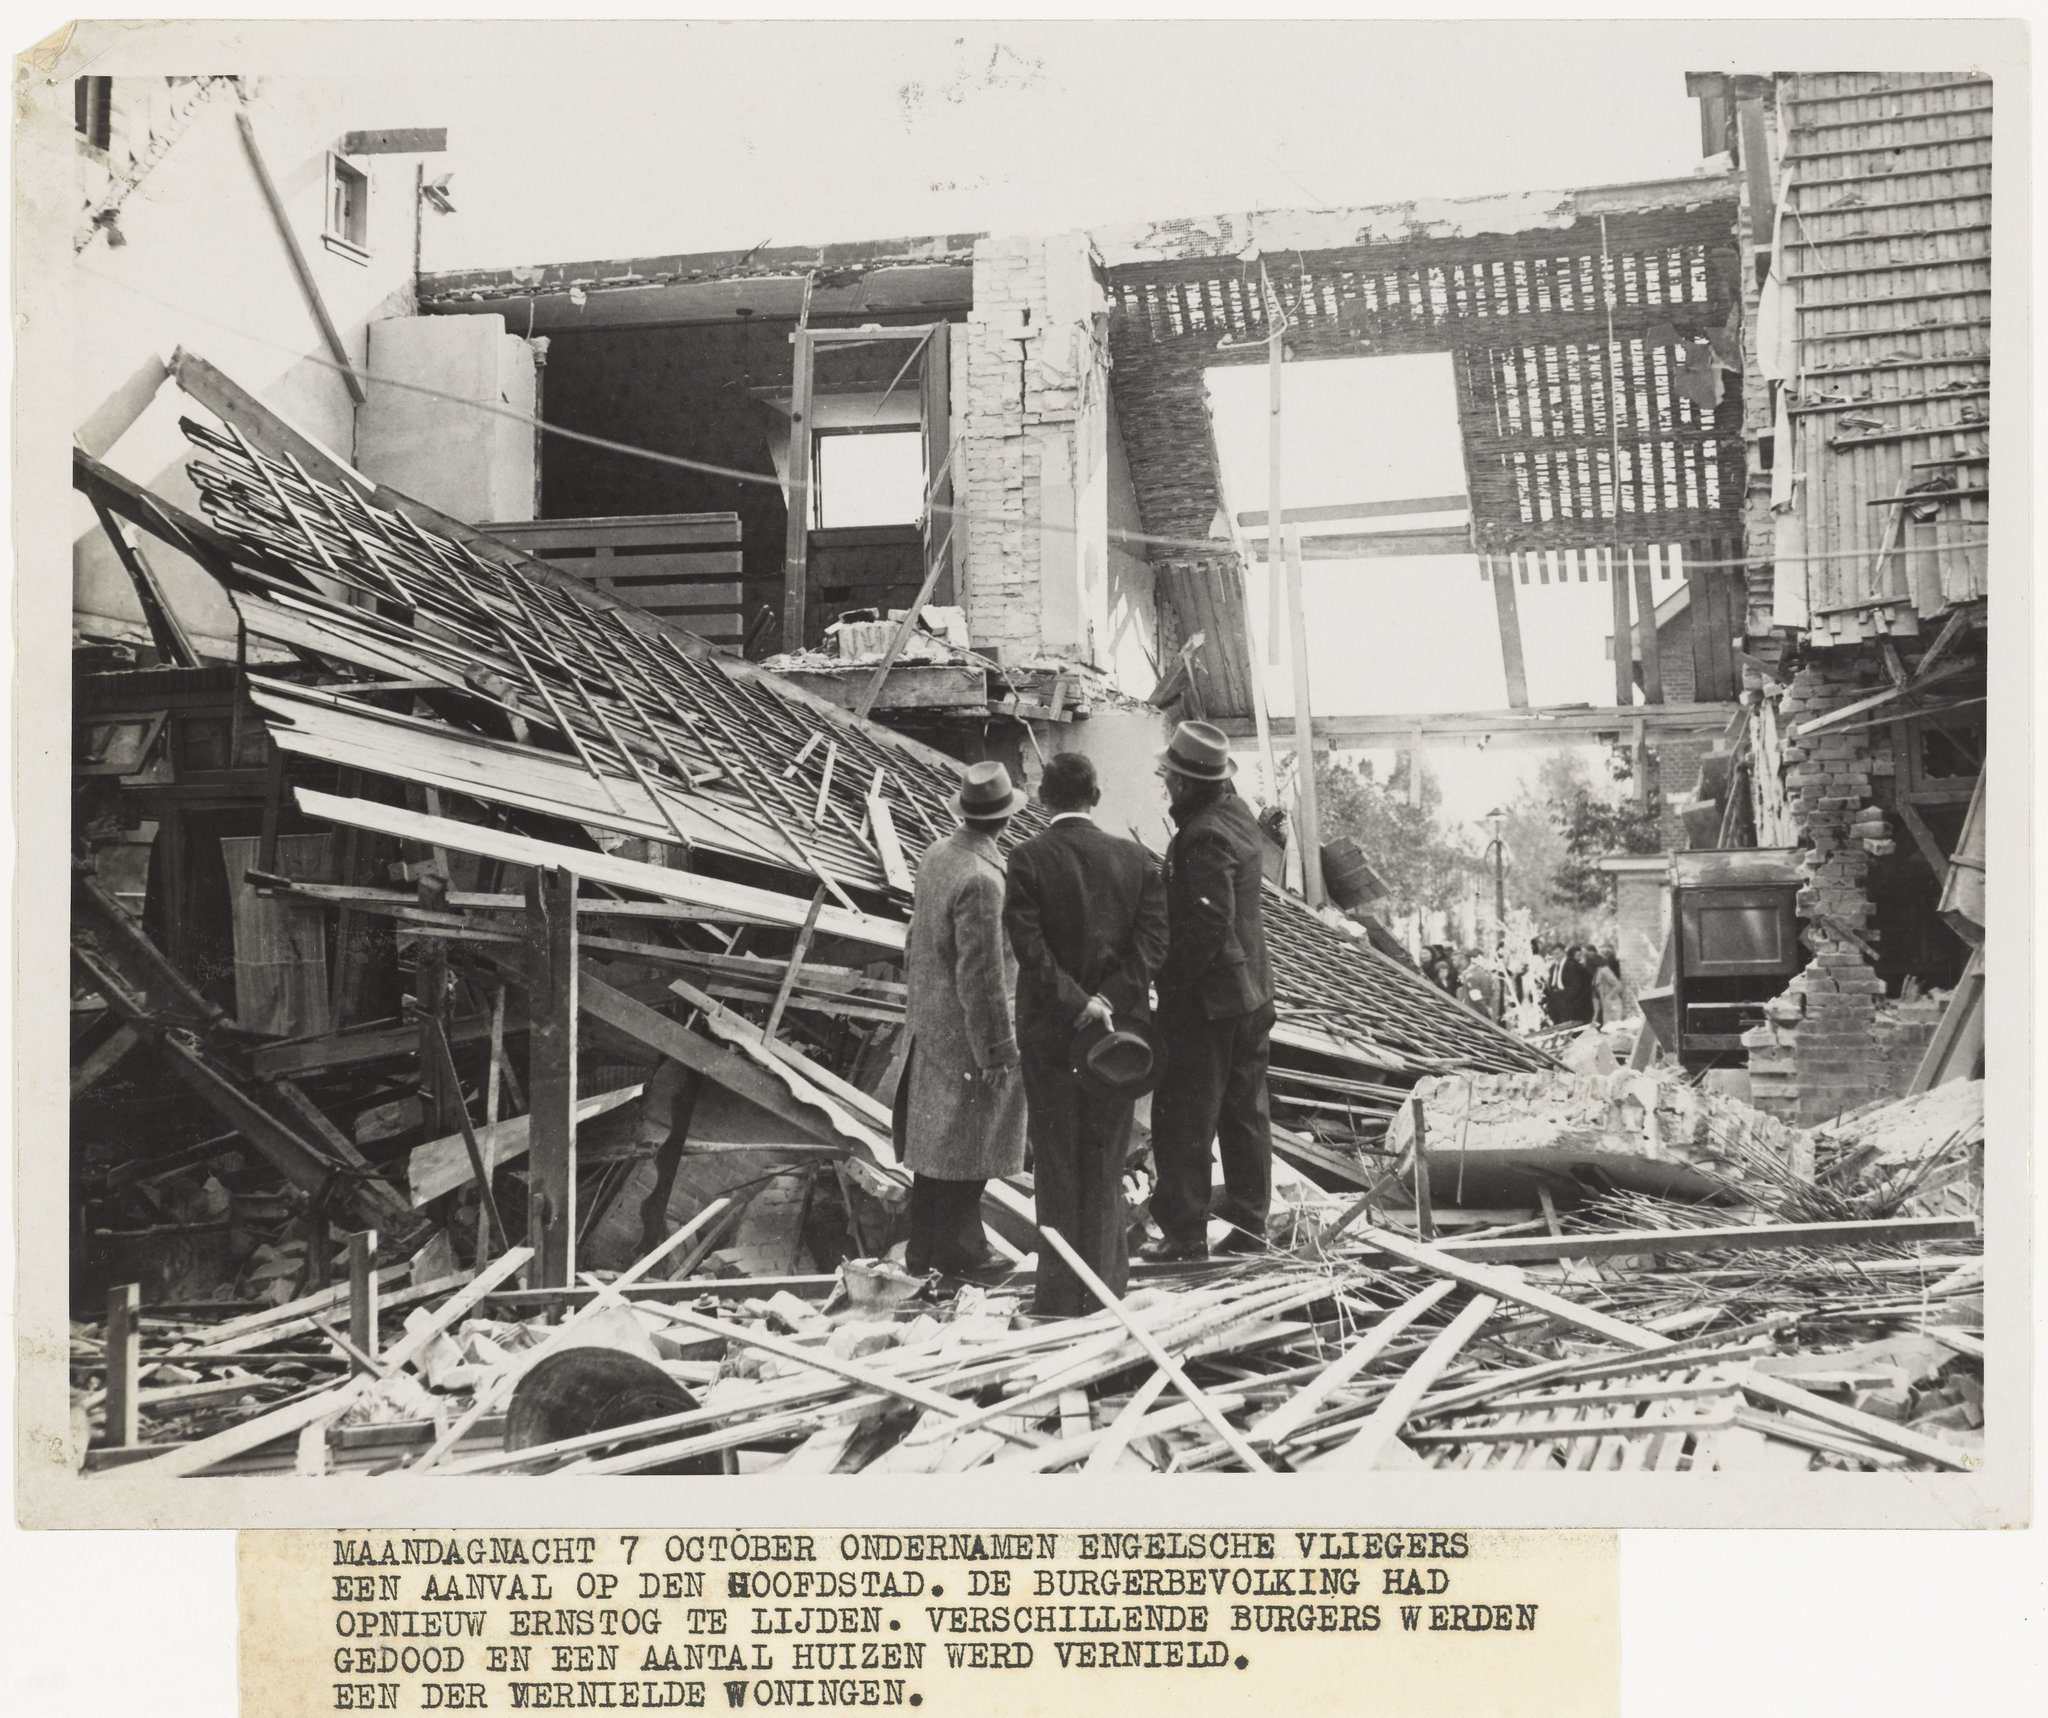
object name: photograph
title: Verwoeste huizen na bomaanval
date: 1940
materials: photographic support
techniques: photography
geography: amsterdam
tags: devastated, ruined place or city (~ warfare), amsterdam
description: Verwoeste huizen na een aanval van de Engelsen op 7 oktober, aldus het bijschrift. Pas 10 dagen later voor publicatie vrijgegeven. Tekststrookje aan foto geplakt.